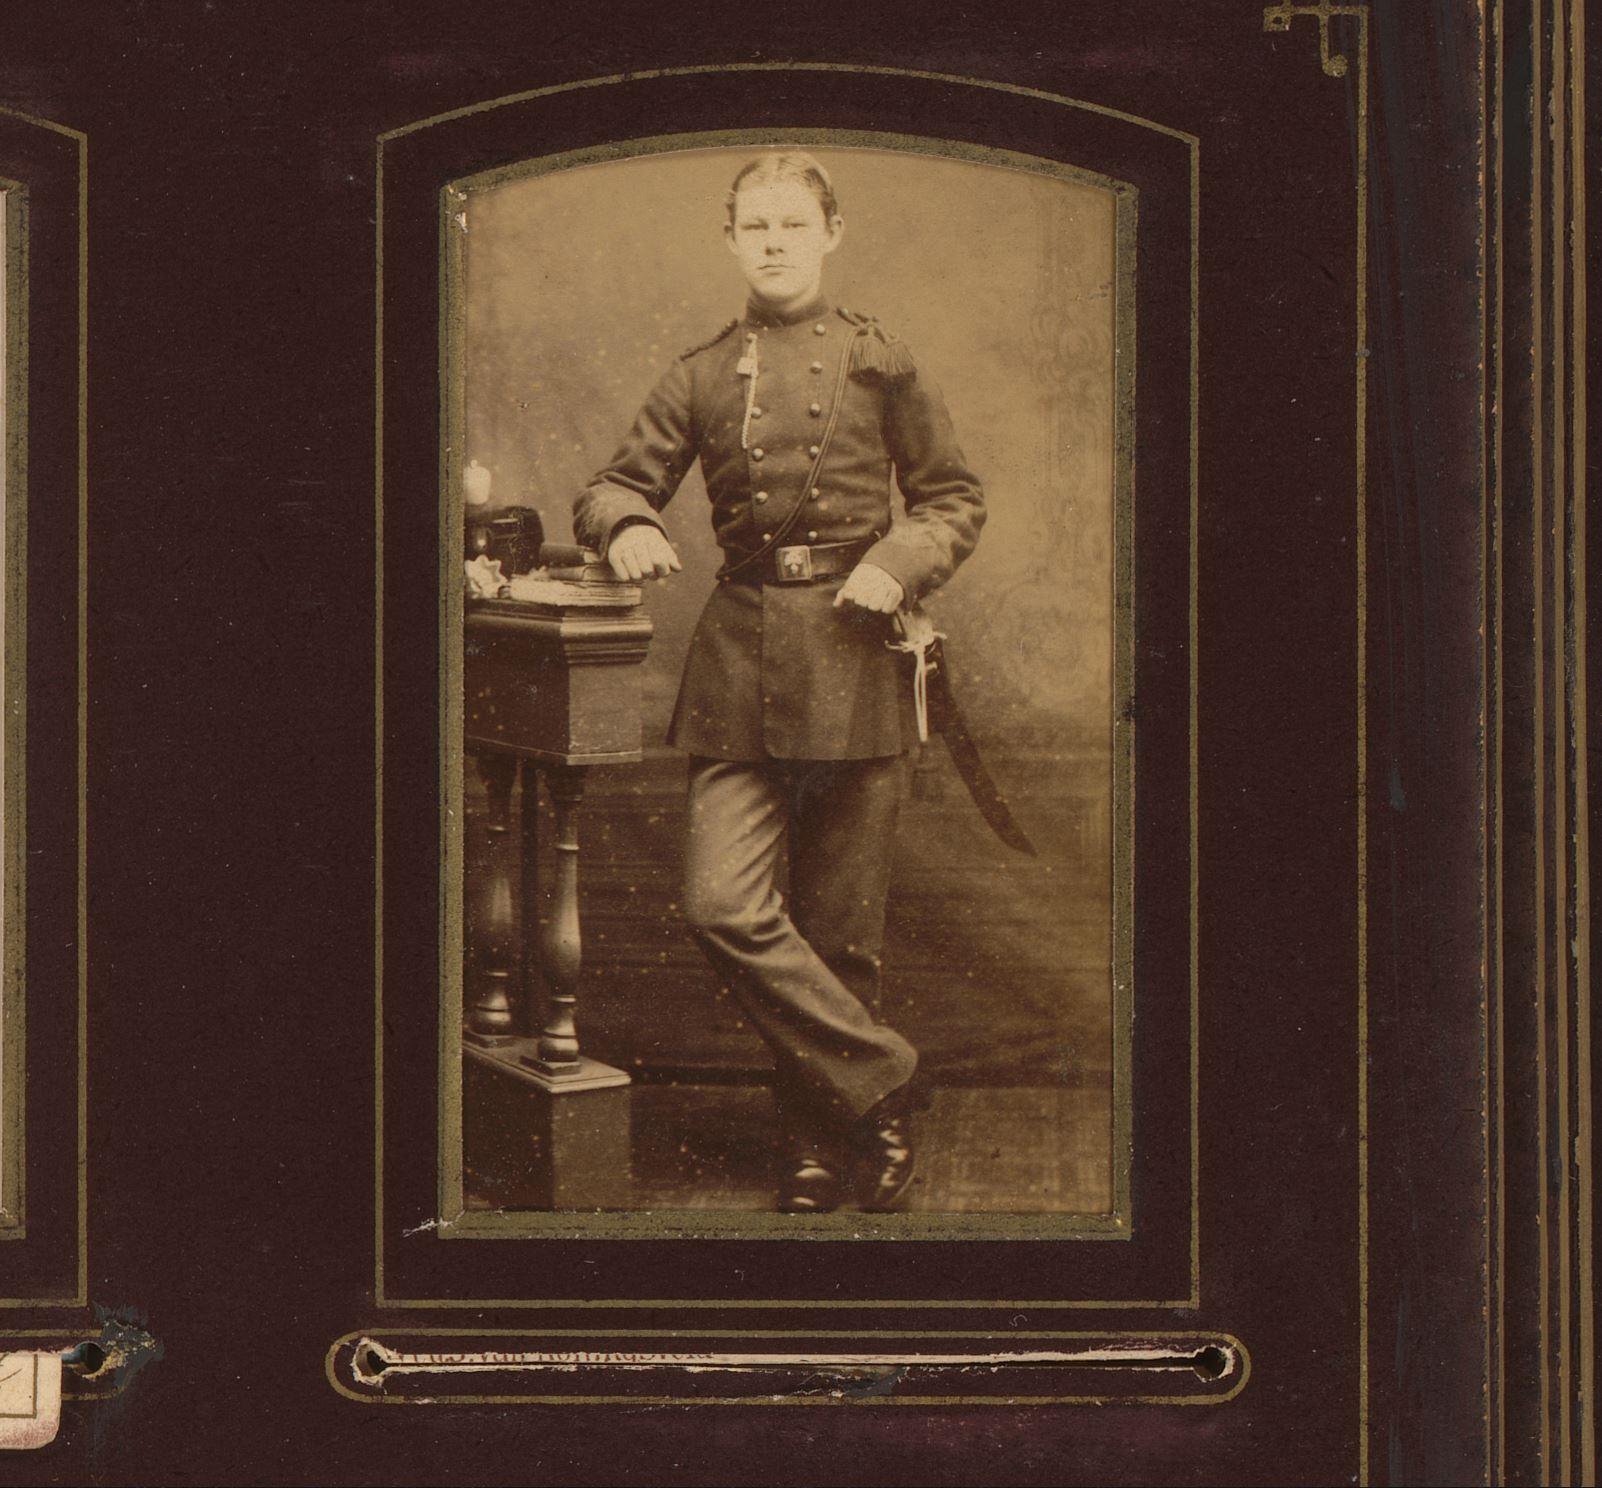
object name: album leaf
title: Portret van een jonge man in militair uniform, leunend op een balustrade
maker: veuve j. van koningsveld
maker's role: fotograaf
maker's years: 1828-1907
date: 1884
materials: cardboard, photographic support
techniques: albumen print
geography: deventer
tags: historical persons, youth, adolescent, balustrade, (military) uniforms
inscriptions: inscription: ‘Wed. J./ van/ Koningsveld/ Photographisch/ Atelier/ Deventer/ en Kampen./ De plaat blijft tot nabestelling bewaard.’